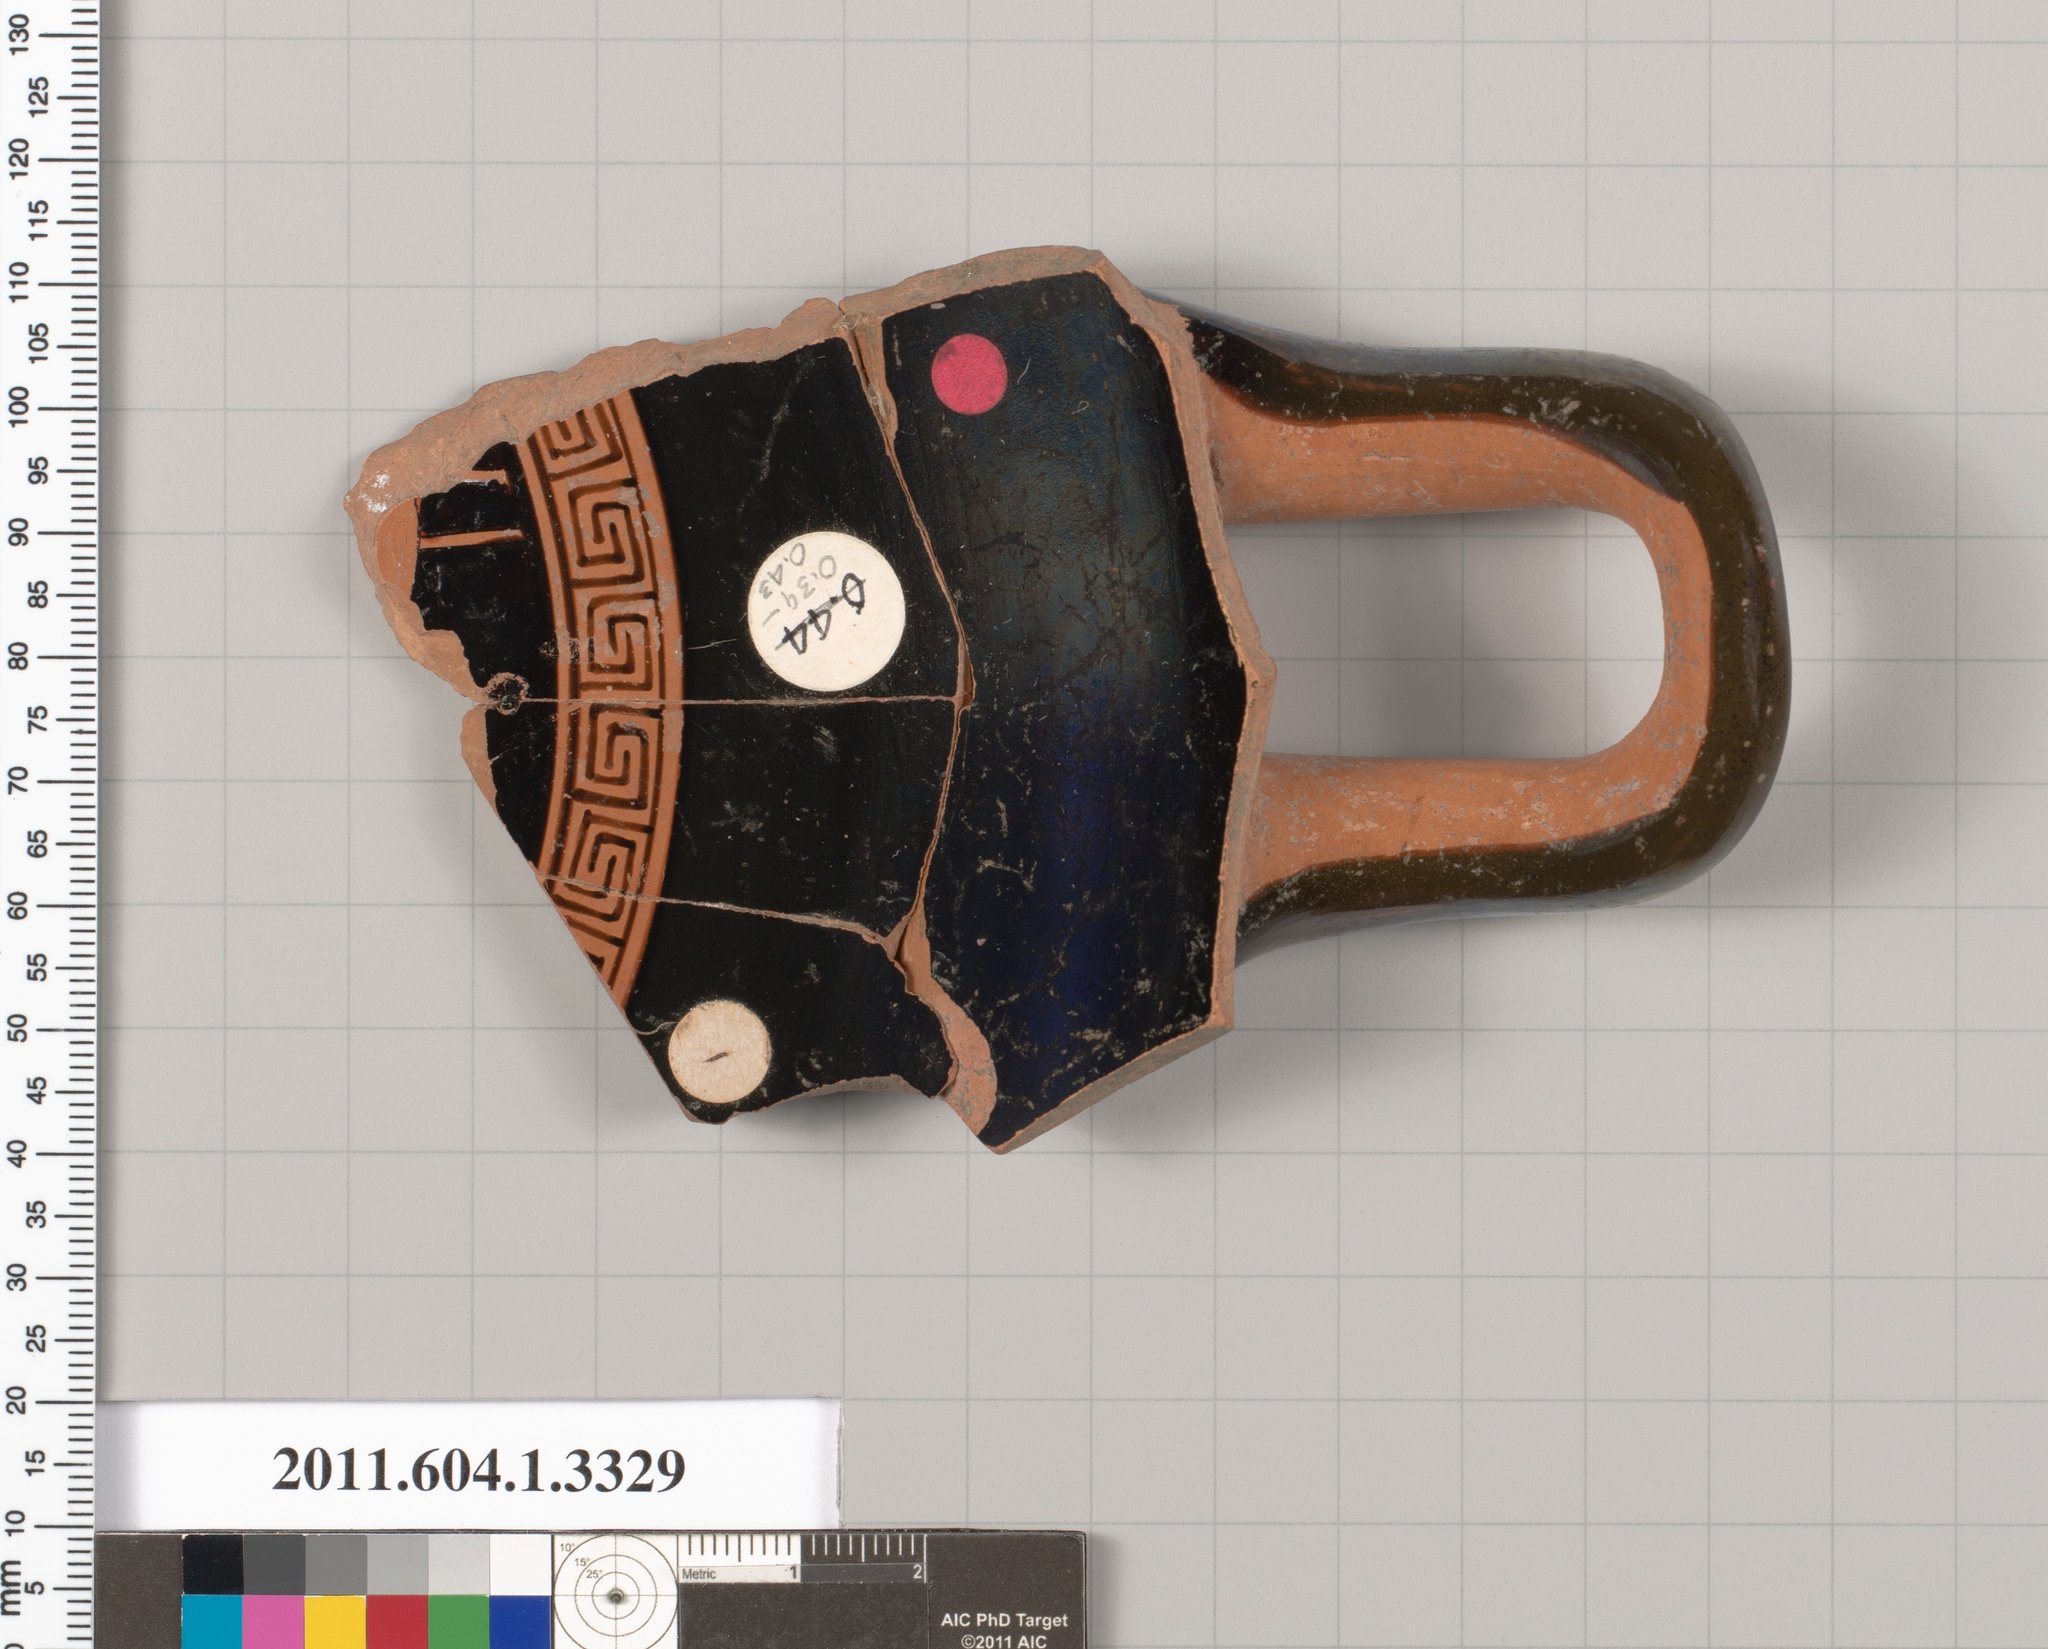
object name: kylix fragment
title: Terracotta fragment of a kylix (drinking cup)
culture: greek, attic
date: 500-476 BCE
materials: terracotta